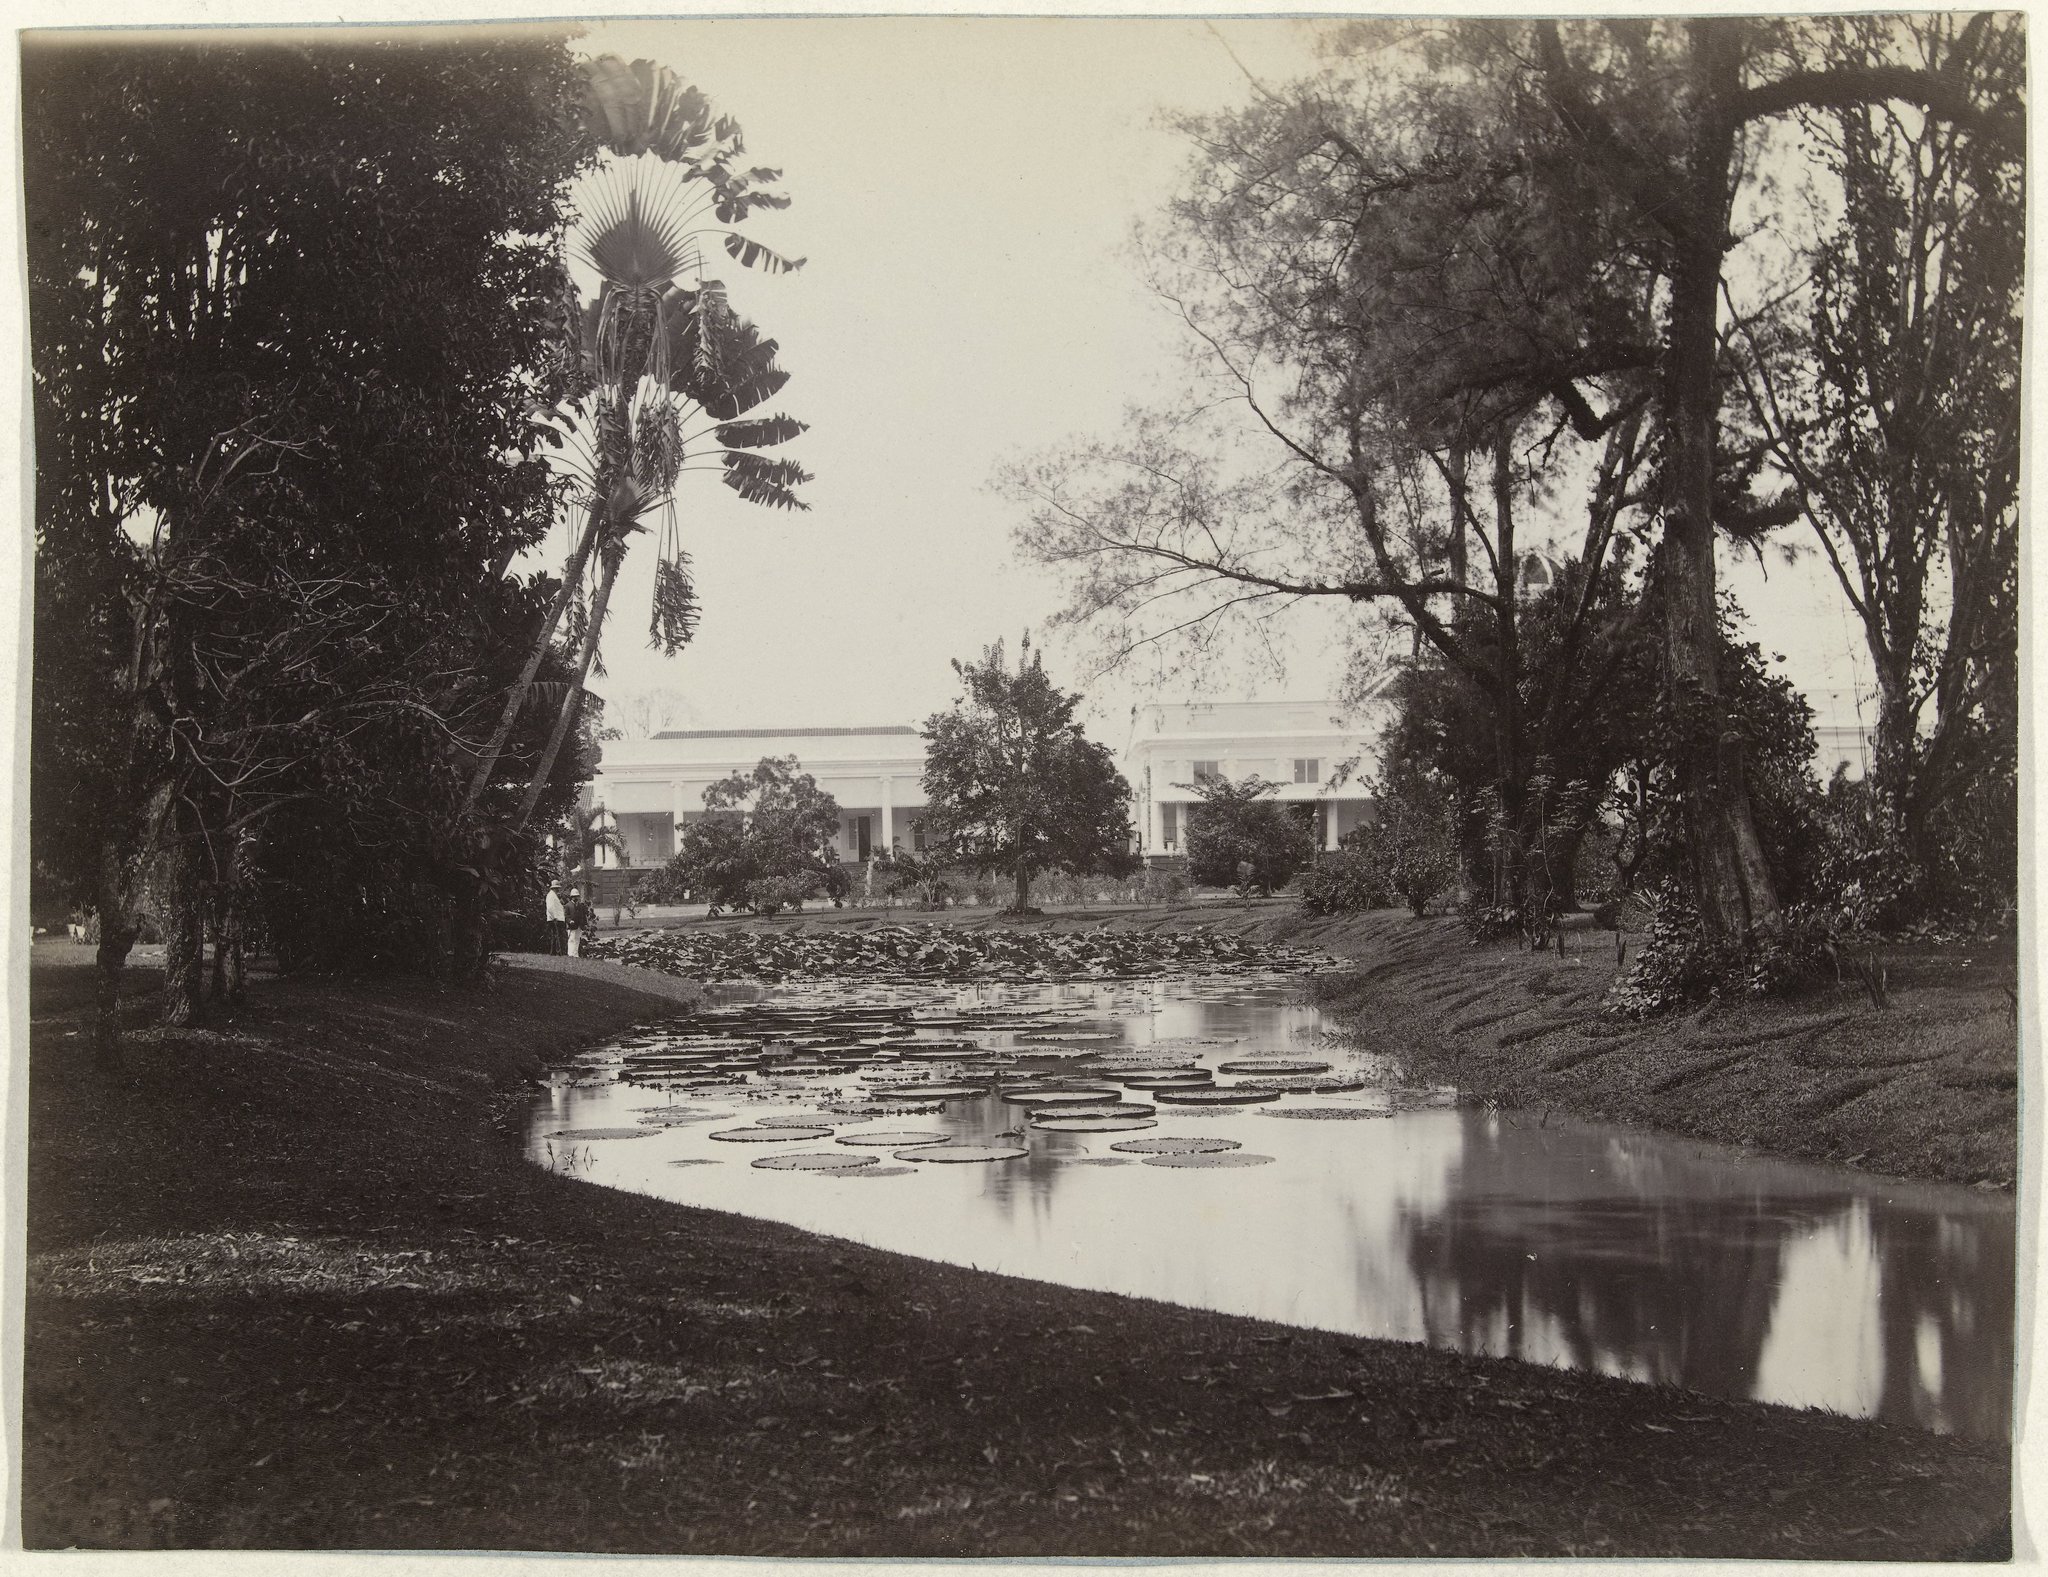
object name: photograph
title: Paleis gouverneur te Buitenzorg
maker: Anonymous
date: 1870-1900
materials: paper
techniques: albumen print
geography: indonesia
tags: palace, garden pond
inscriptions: inscription: ‘Paleis gouverneur te/ Buitenzorg’